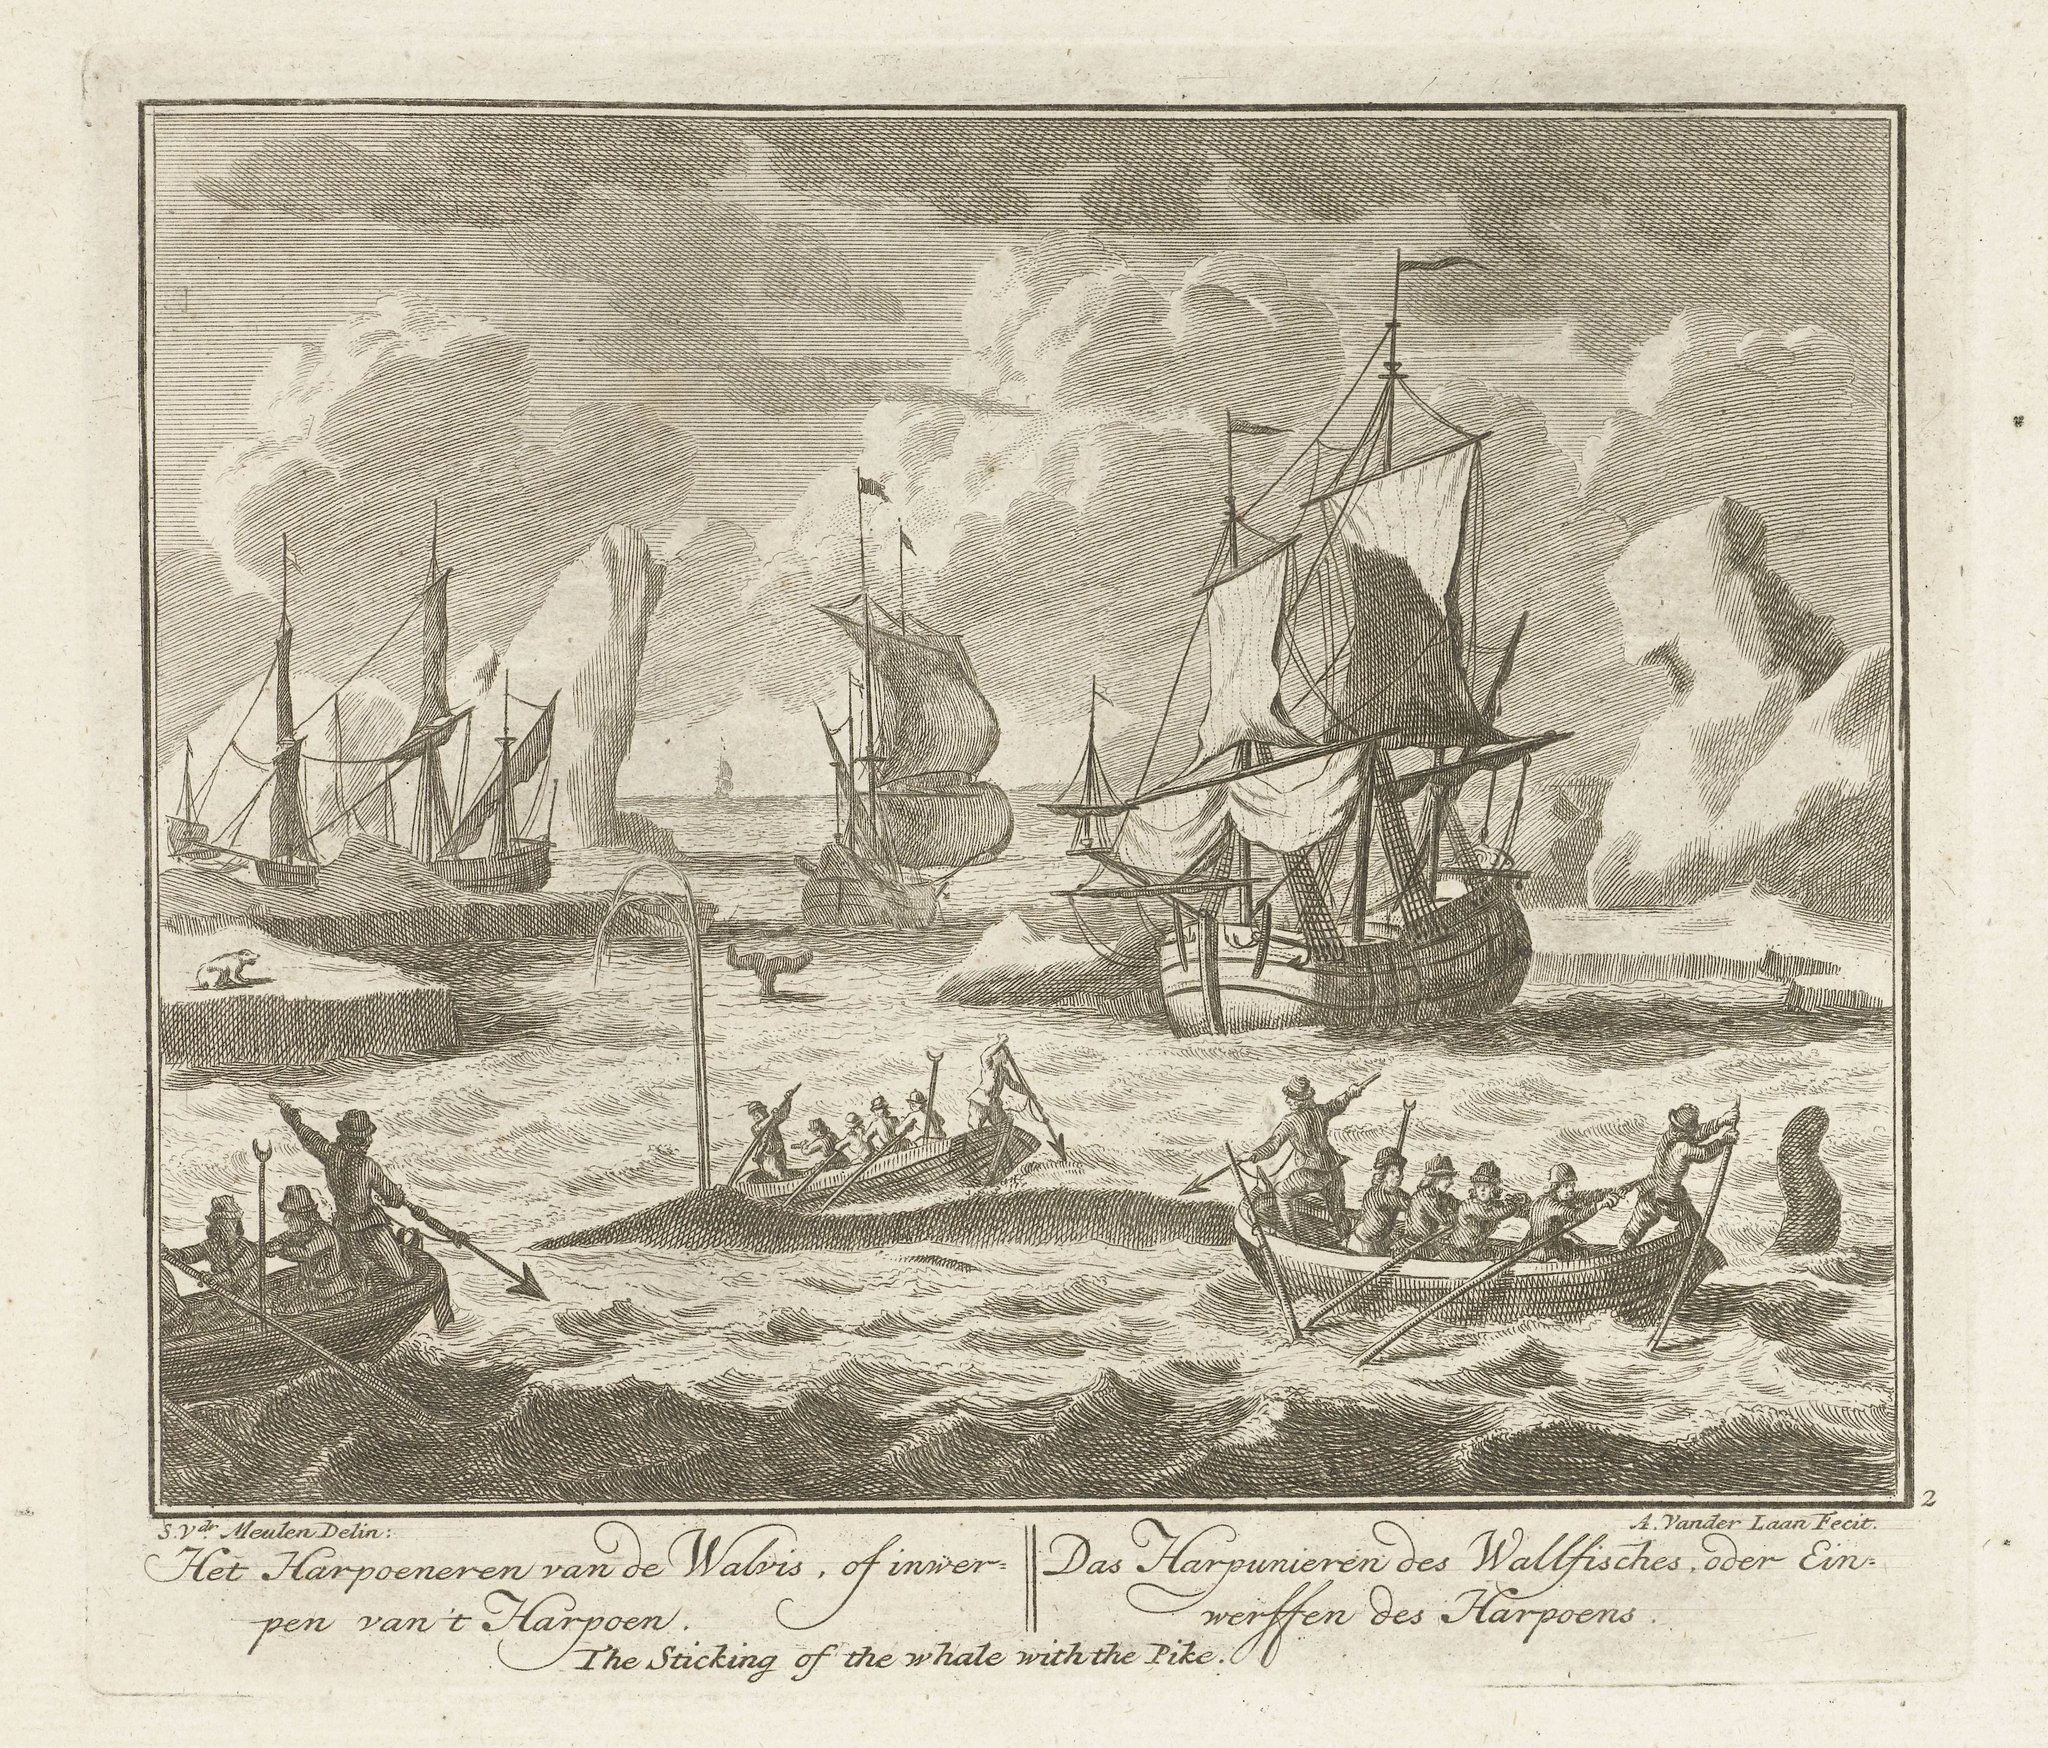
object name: print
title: Walvisvangst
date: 1720-1730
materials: paper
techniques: etching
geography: northern netherlands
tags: whale fishery, whaling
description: Het harpoeneren van de walvis vanuit sloepen in de ijszee, ca. 1725. Onderdeel van de serie over de walvisvangst. Gedrukt op hetzelfde blad als nr. 1.